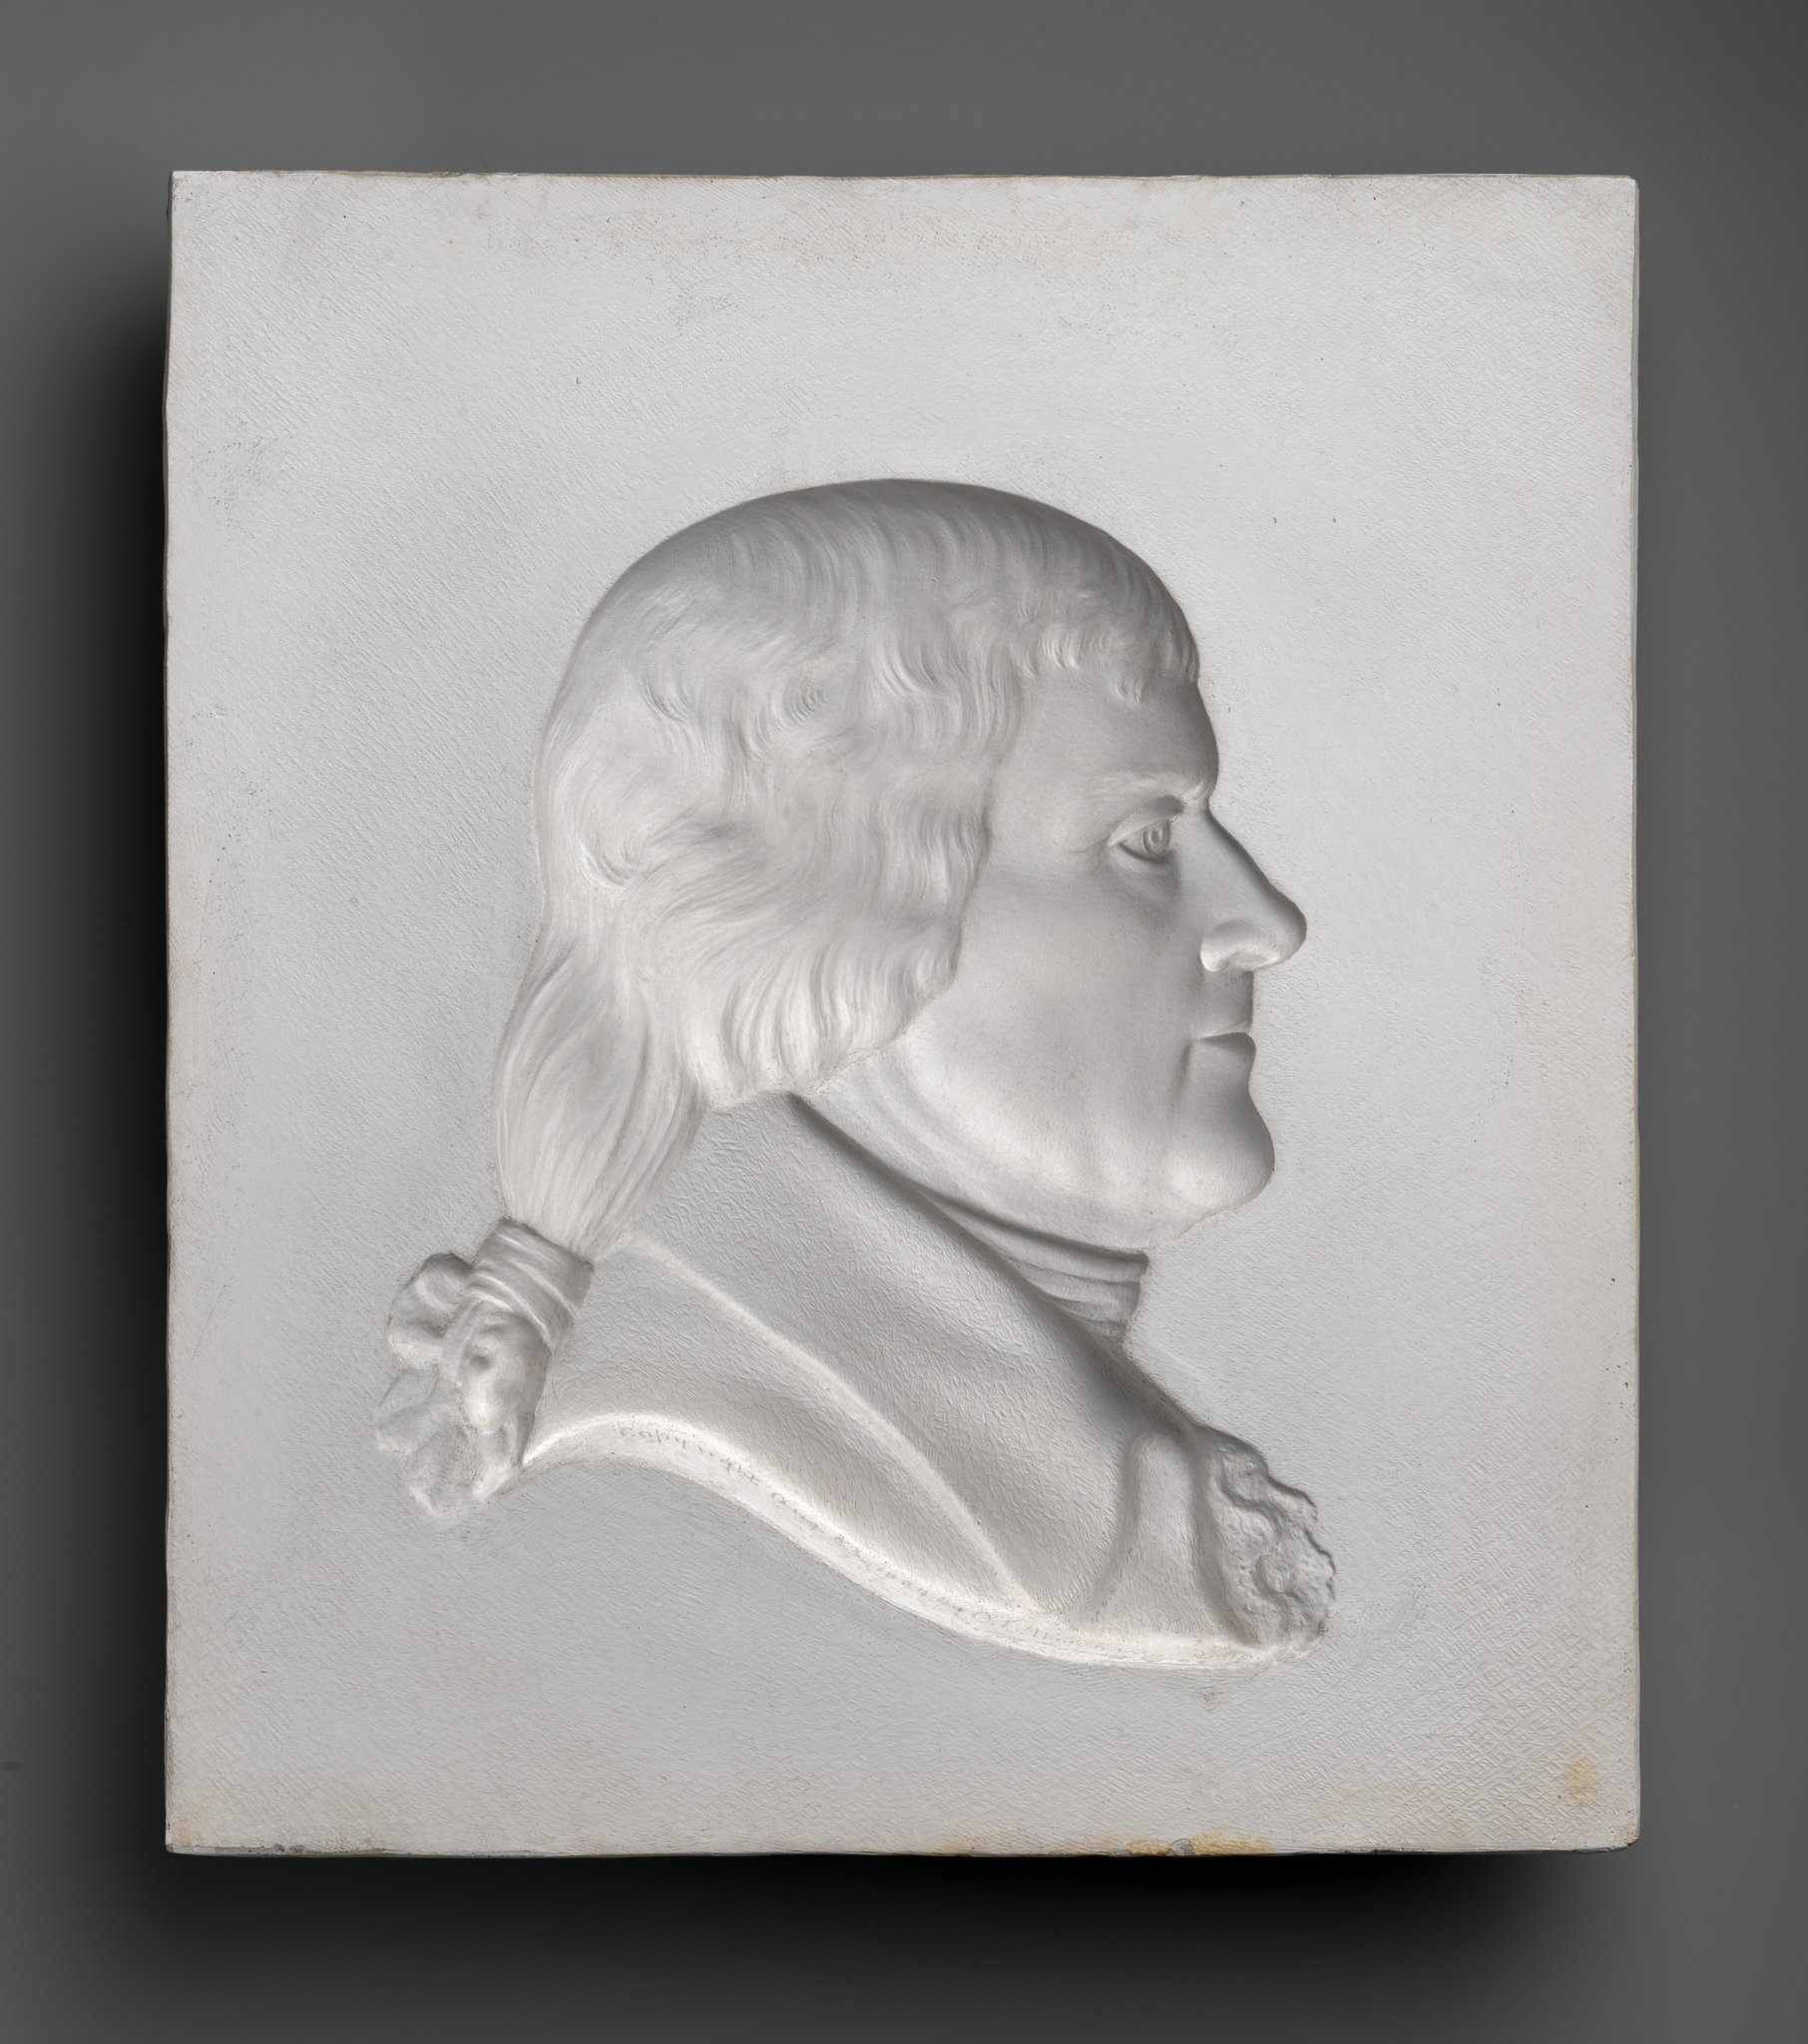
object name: bust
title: Thomas Jefferson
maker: charles l. hogeboom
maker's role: artist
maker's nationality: american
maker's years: 1827-1895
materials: plaster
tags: thomas jefferson